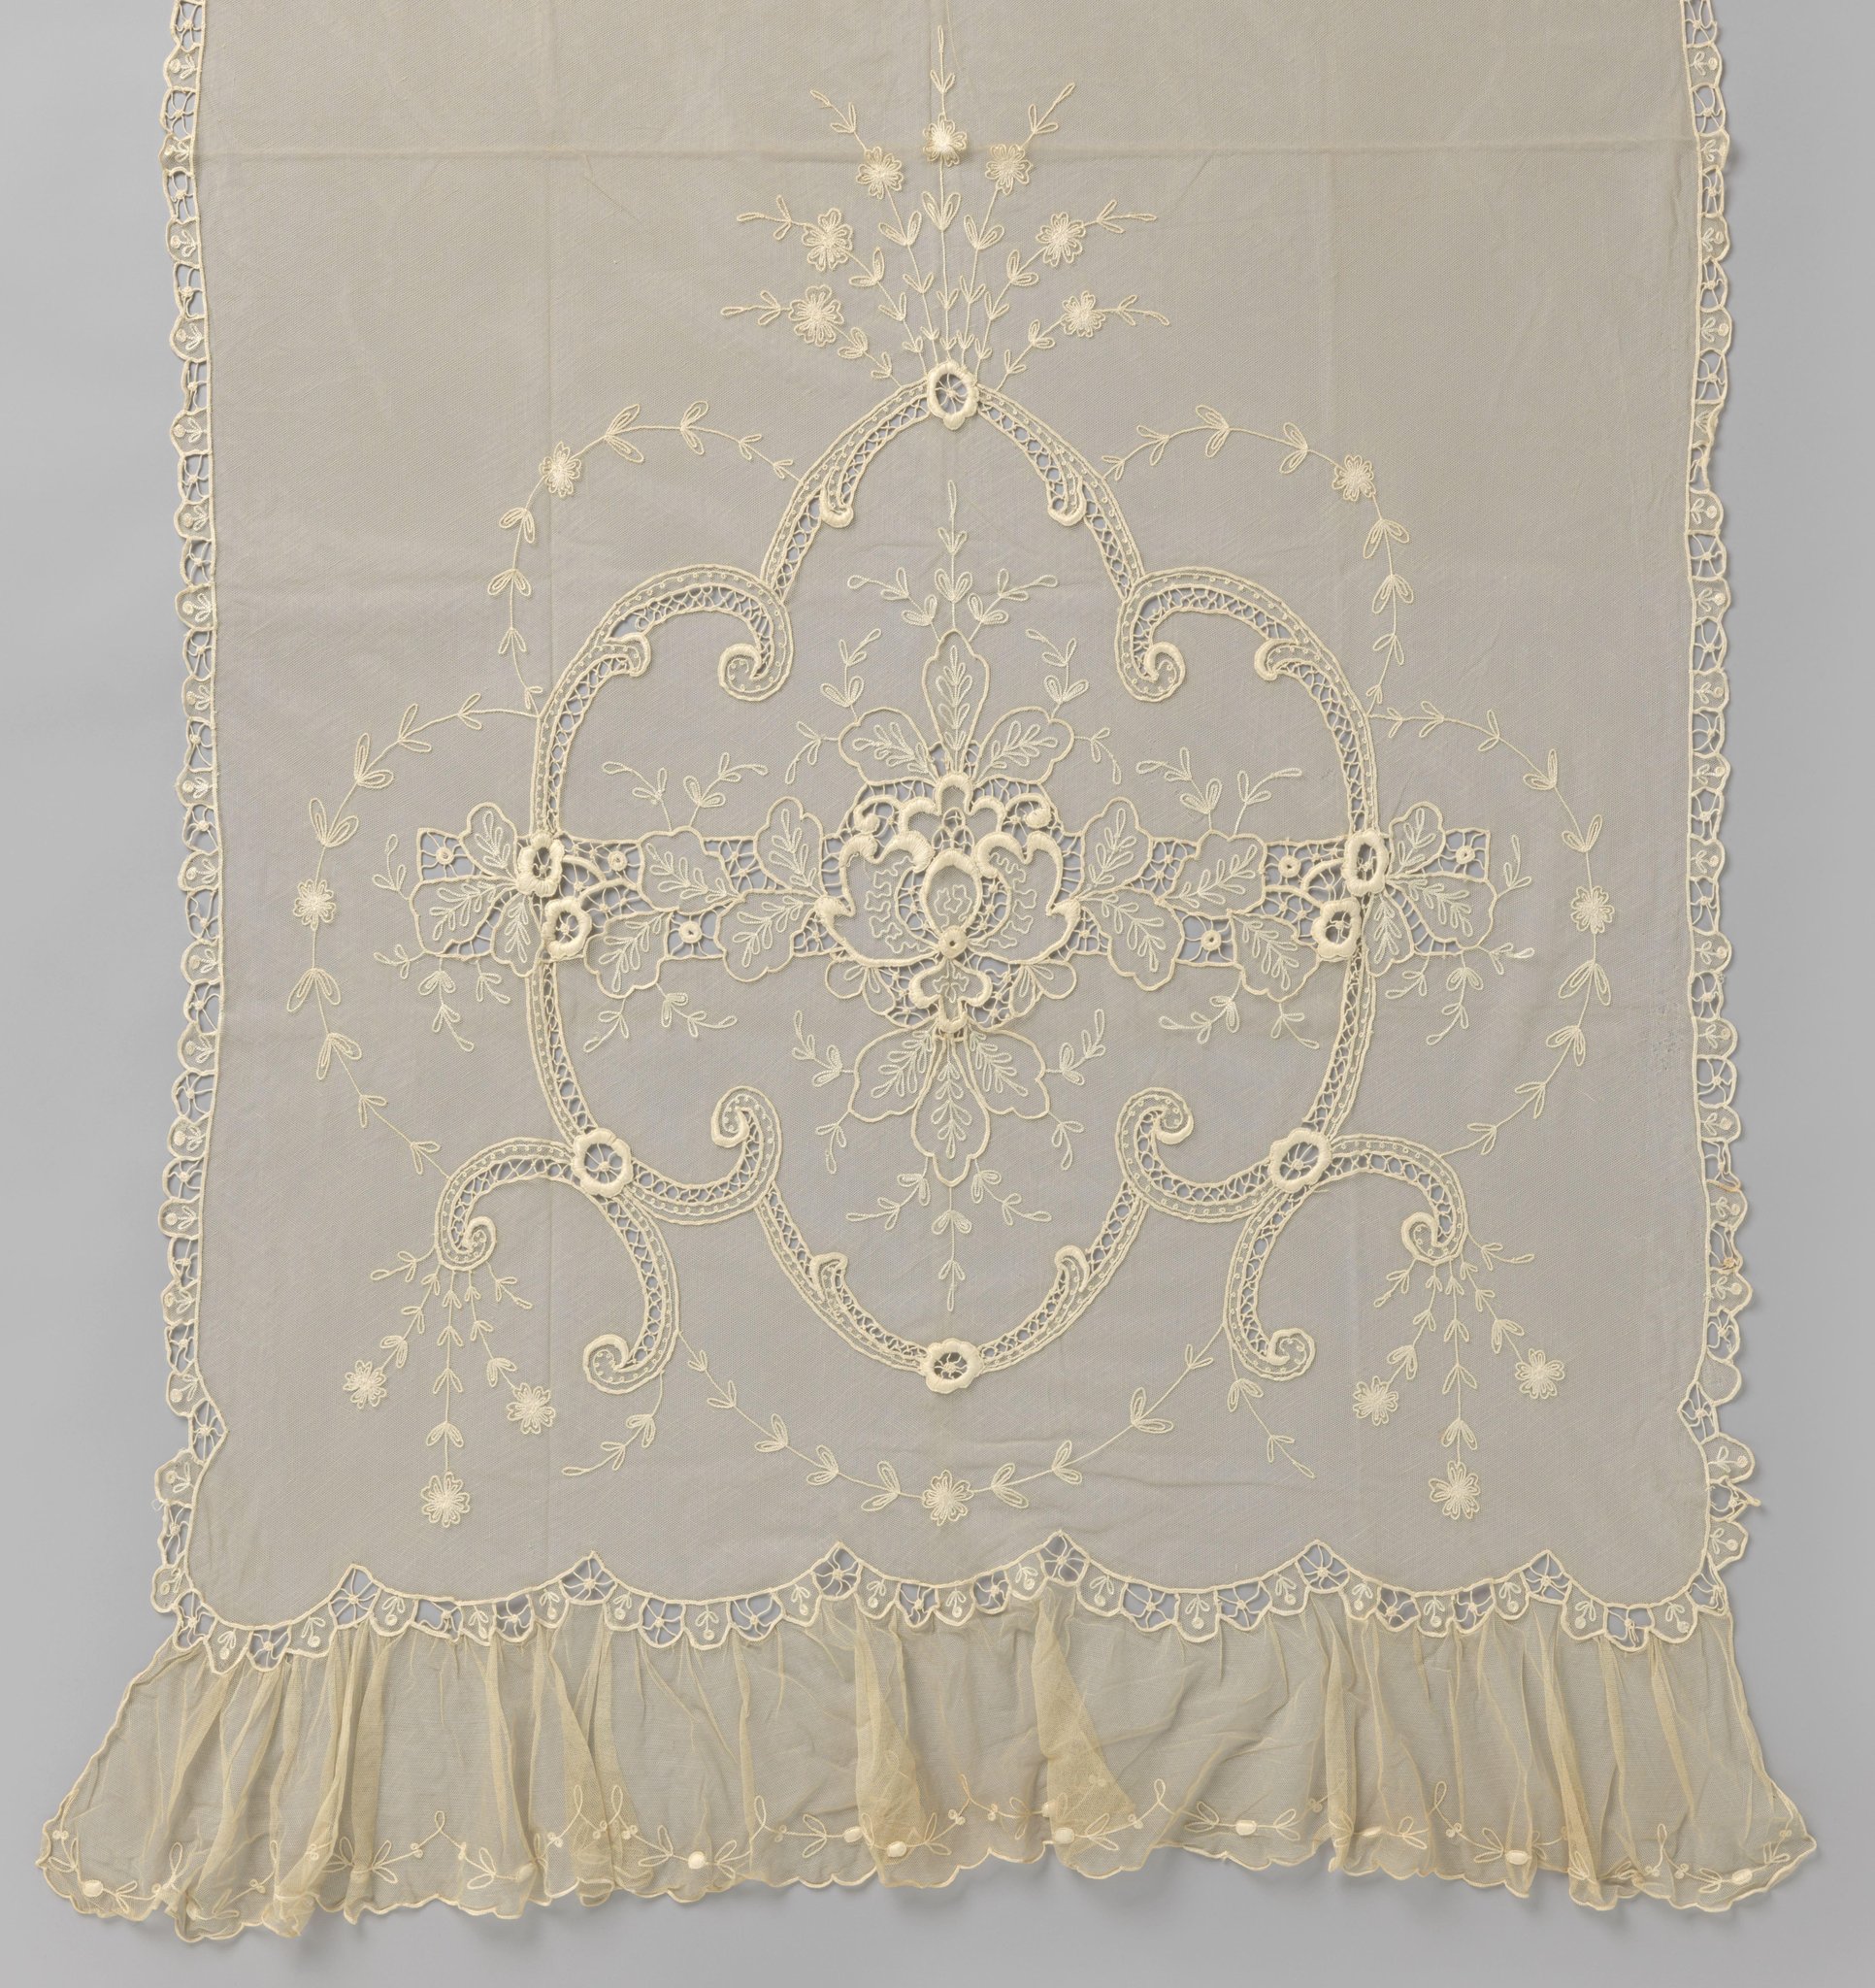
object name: curtain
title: Gordijn van een hemelbed van machinale tule met borduurwerk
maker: Anonymous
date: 1890-1910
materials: fiber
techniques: embroidered, stitch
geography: france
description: Gordijn van een hemelbed van machinale tule in wit geborduurd met ketting- en festonsteek met opengewerkte partijen op de manier van Richelieu-borduurwerk. Groot bloem- en bladmotief binnen een cartouche van C-voluten, waaromheen bloemslingers en takken.